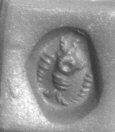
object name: stamp seal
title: Seal with head of an antelope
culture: sasanian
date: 201-700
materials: mineral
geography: iran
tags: animals